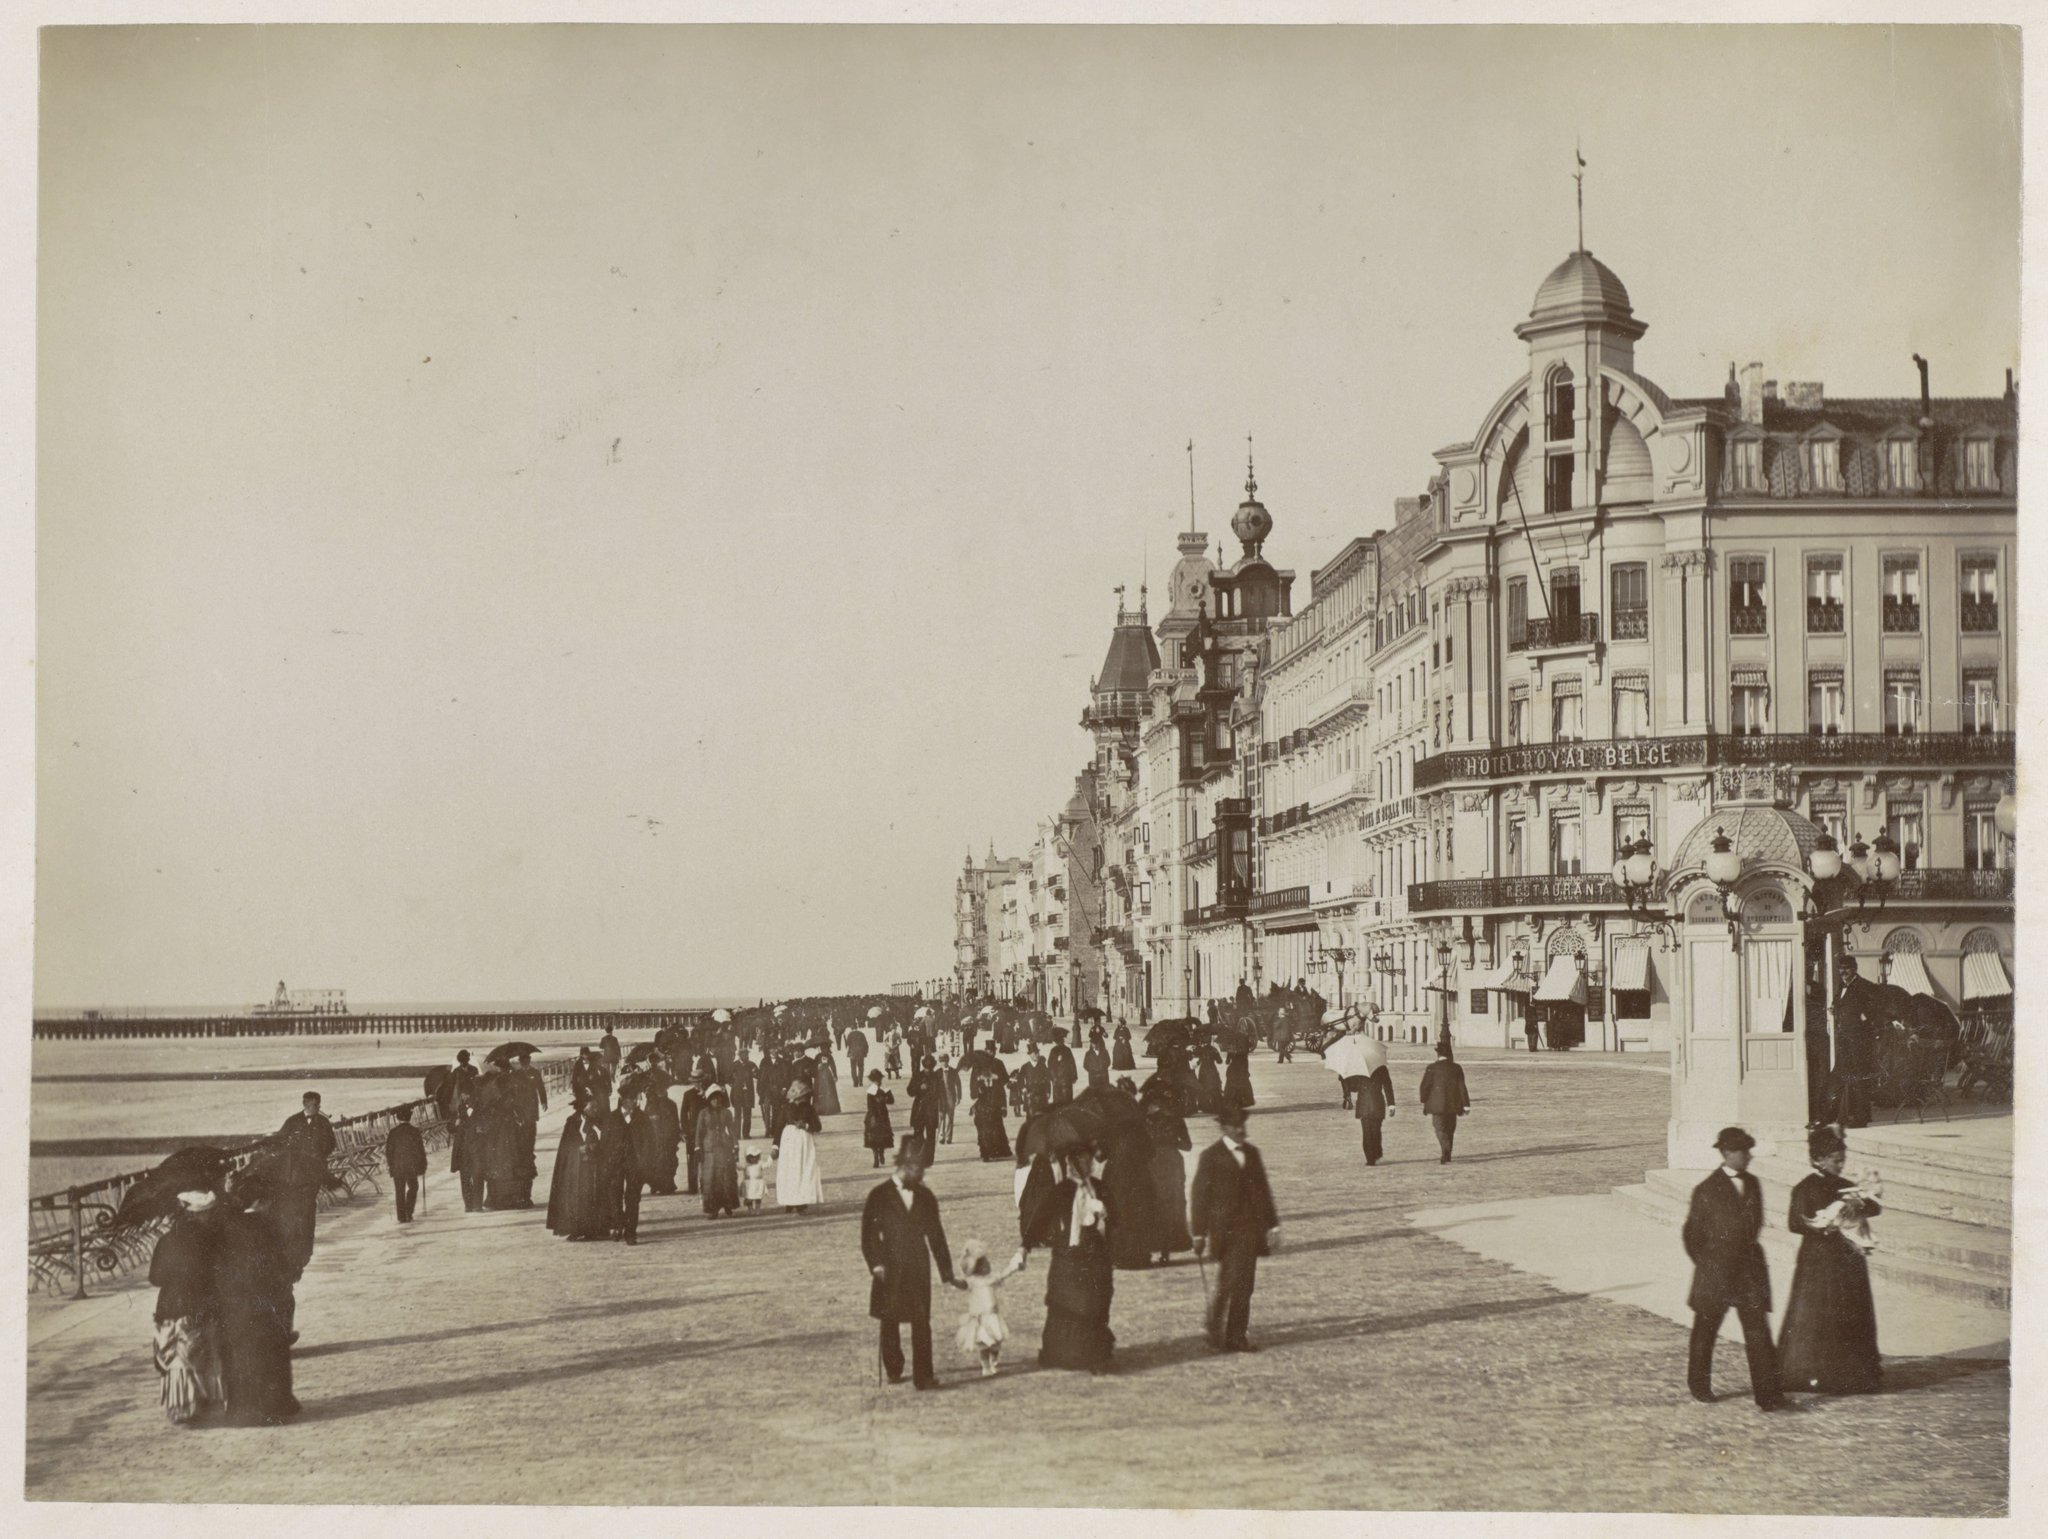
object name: photograph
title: Boulevard met wandelaars en Hotel Royal Belge in Oostende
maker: Anonymous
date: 1878-1890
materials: photographic support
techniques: albumen print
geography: oostende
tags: four-wheeled, animal-drawn vehicle, e.g.: cab, carriage, coach (+ conveyance for transport of persons), strolling, hotel, hostelry, inn, in or beside the water (on the beach)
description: Onderdeel van Reisalbum Europese steden, vermoedelijk Zweeds.